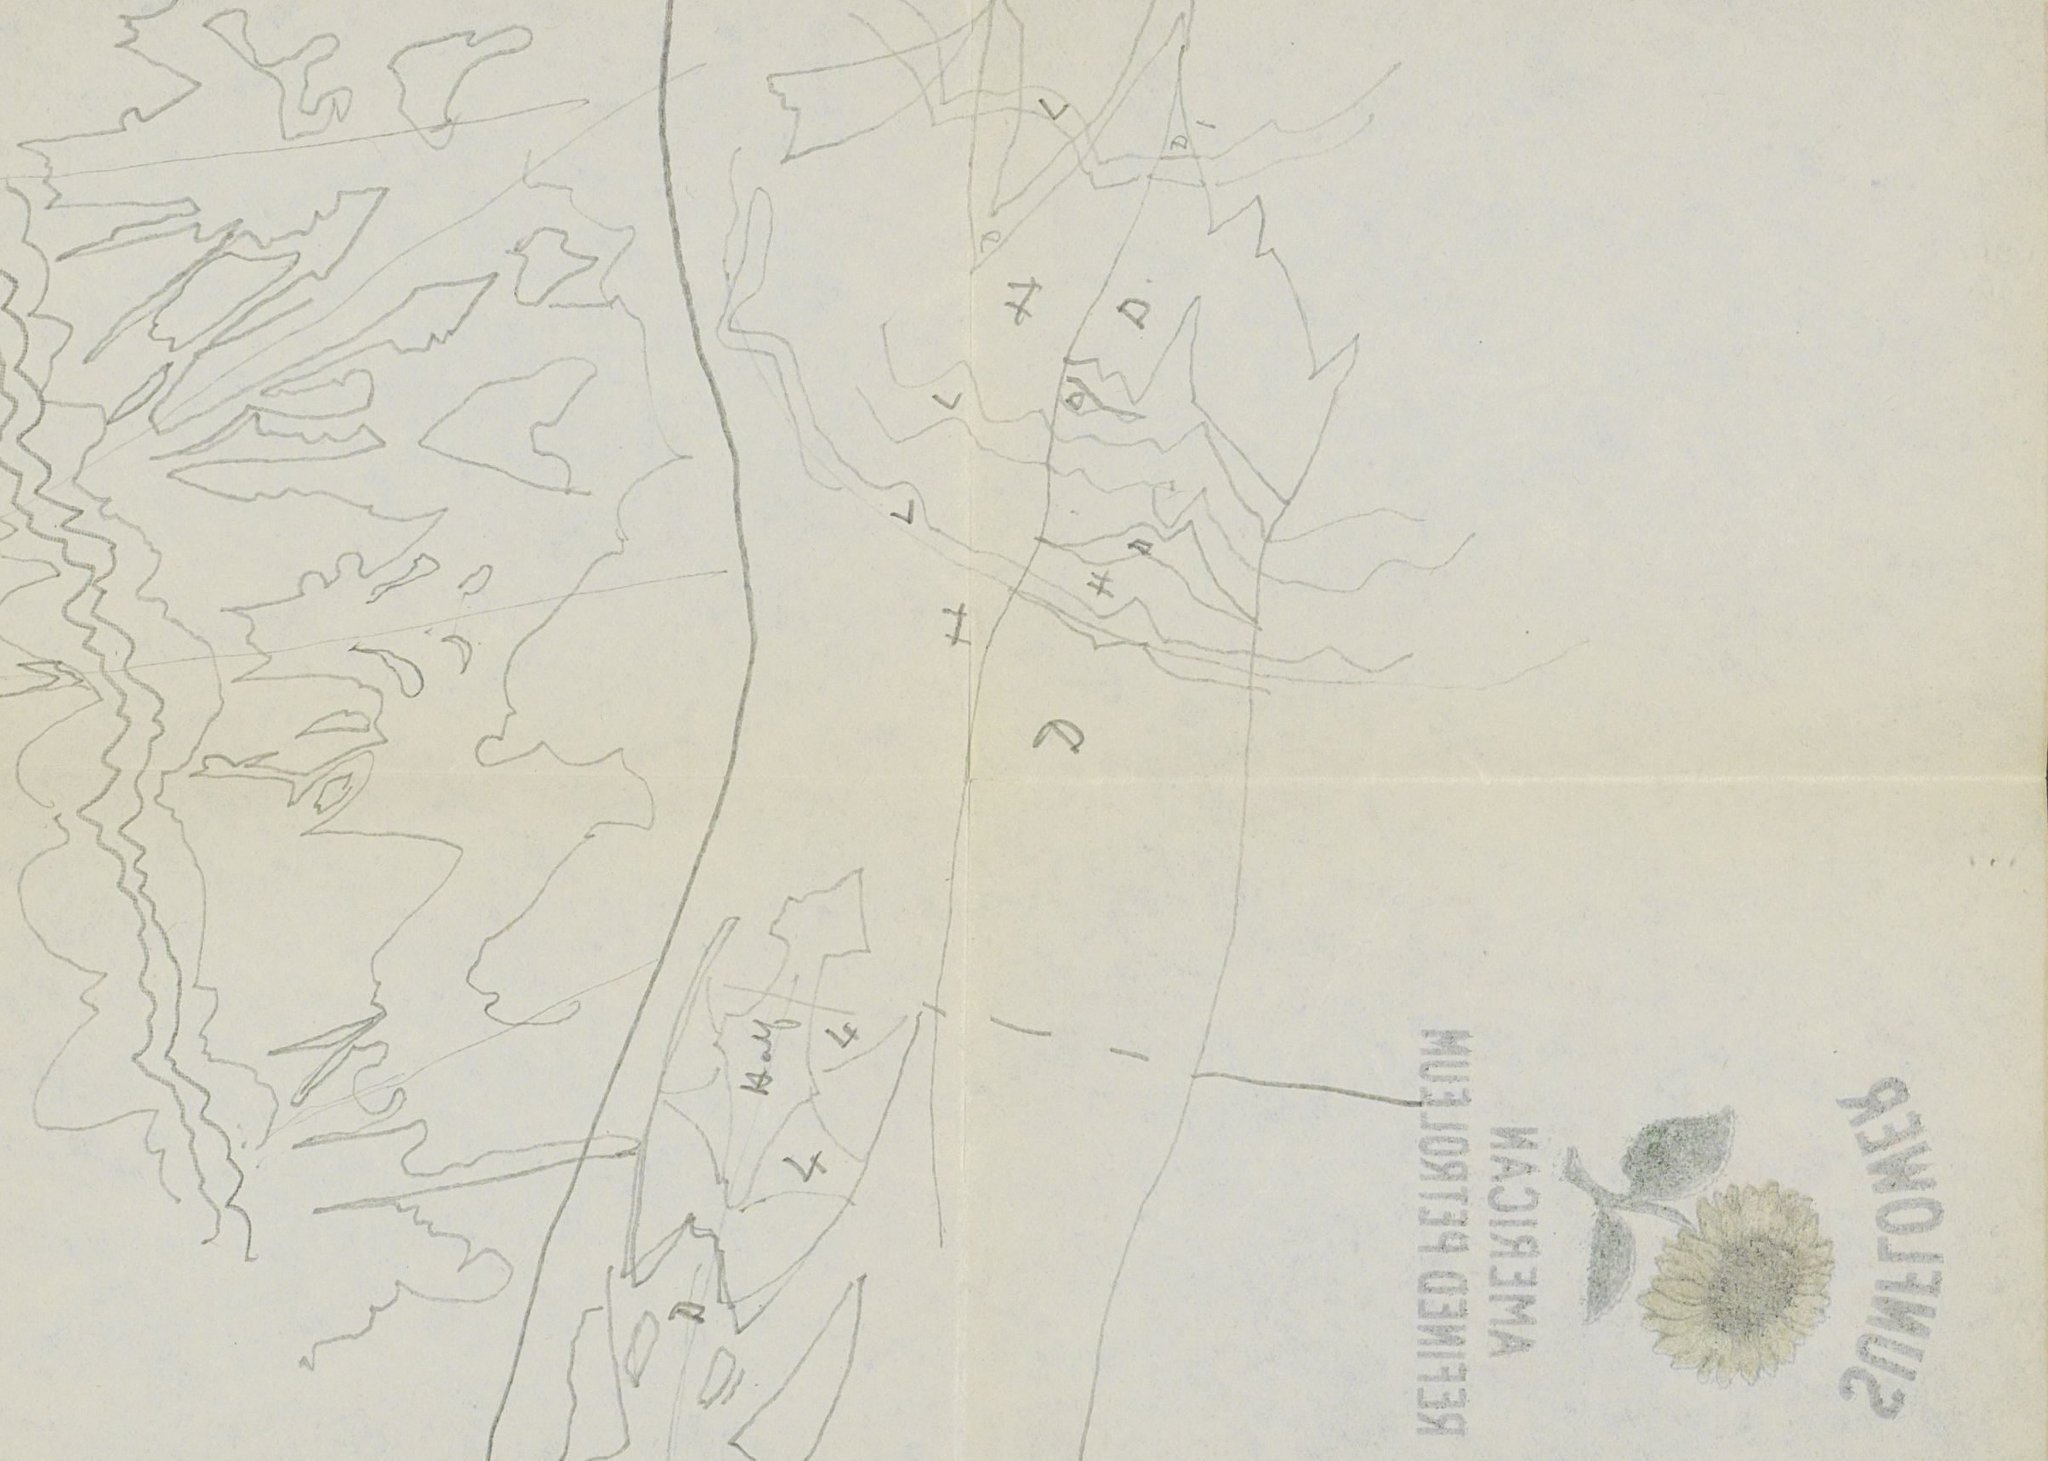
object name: sketchbook leaf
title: Studie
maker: reijer stolk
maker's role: draughtsman, print maker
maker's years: 1896-1945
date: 1916-1945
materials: paper, pencil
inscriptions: annotation: ‘[...]half’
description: Losse tekening tussen blad 11 verso en 12 recto uit een schetsboek met 60 bladen.